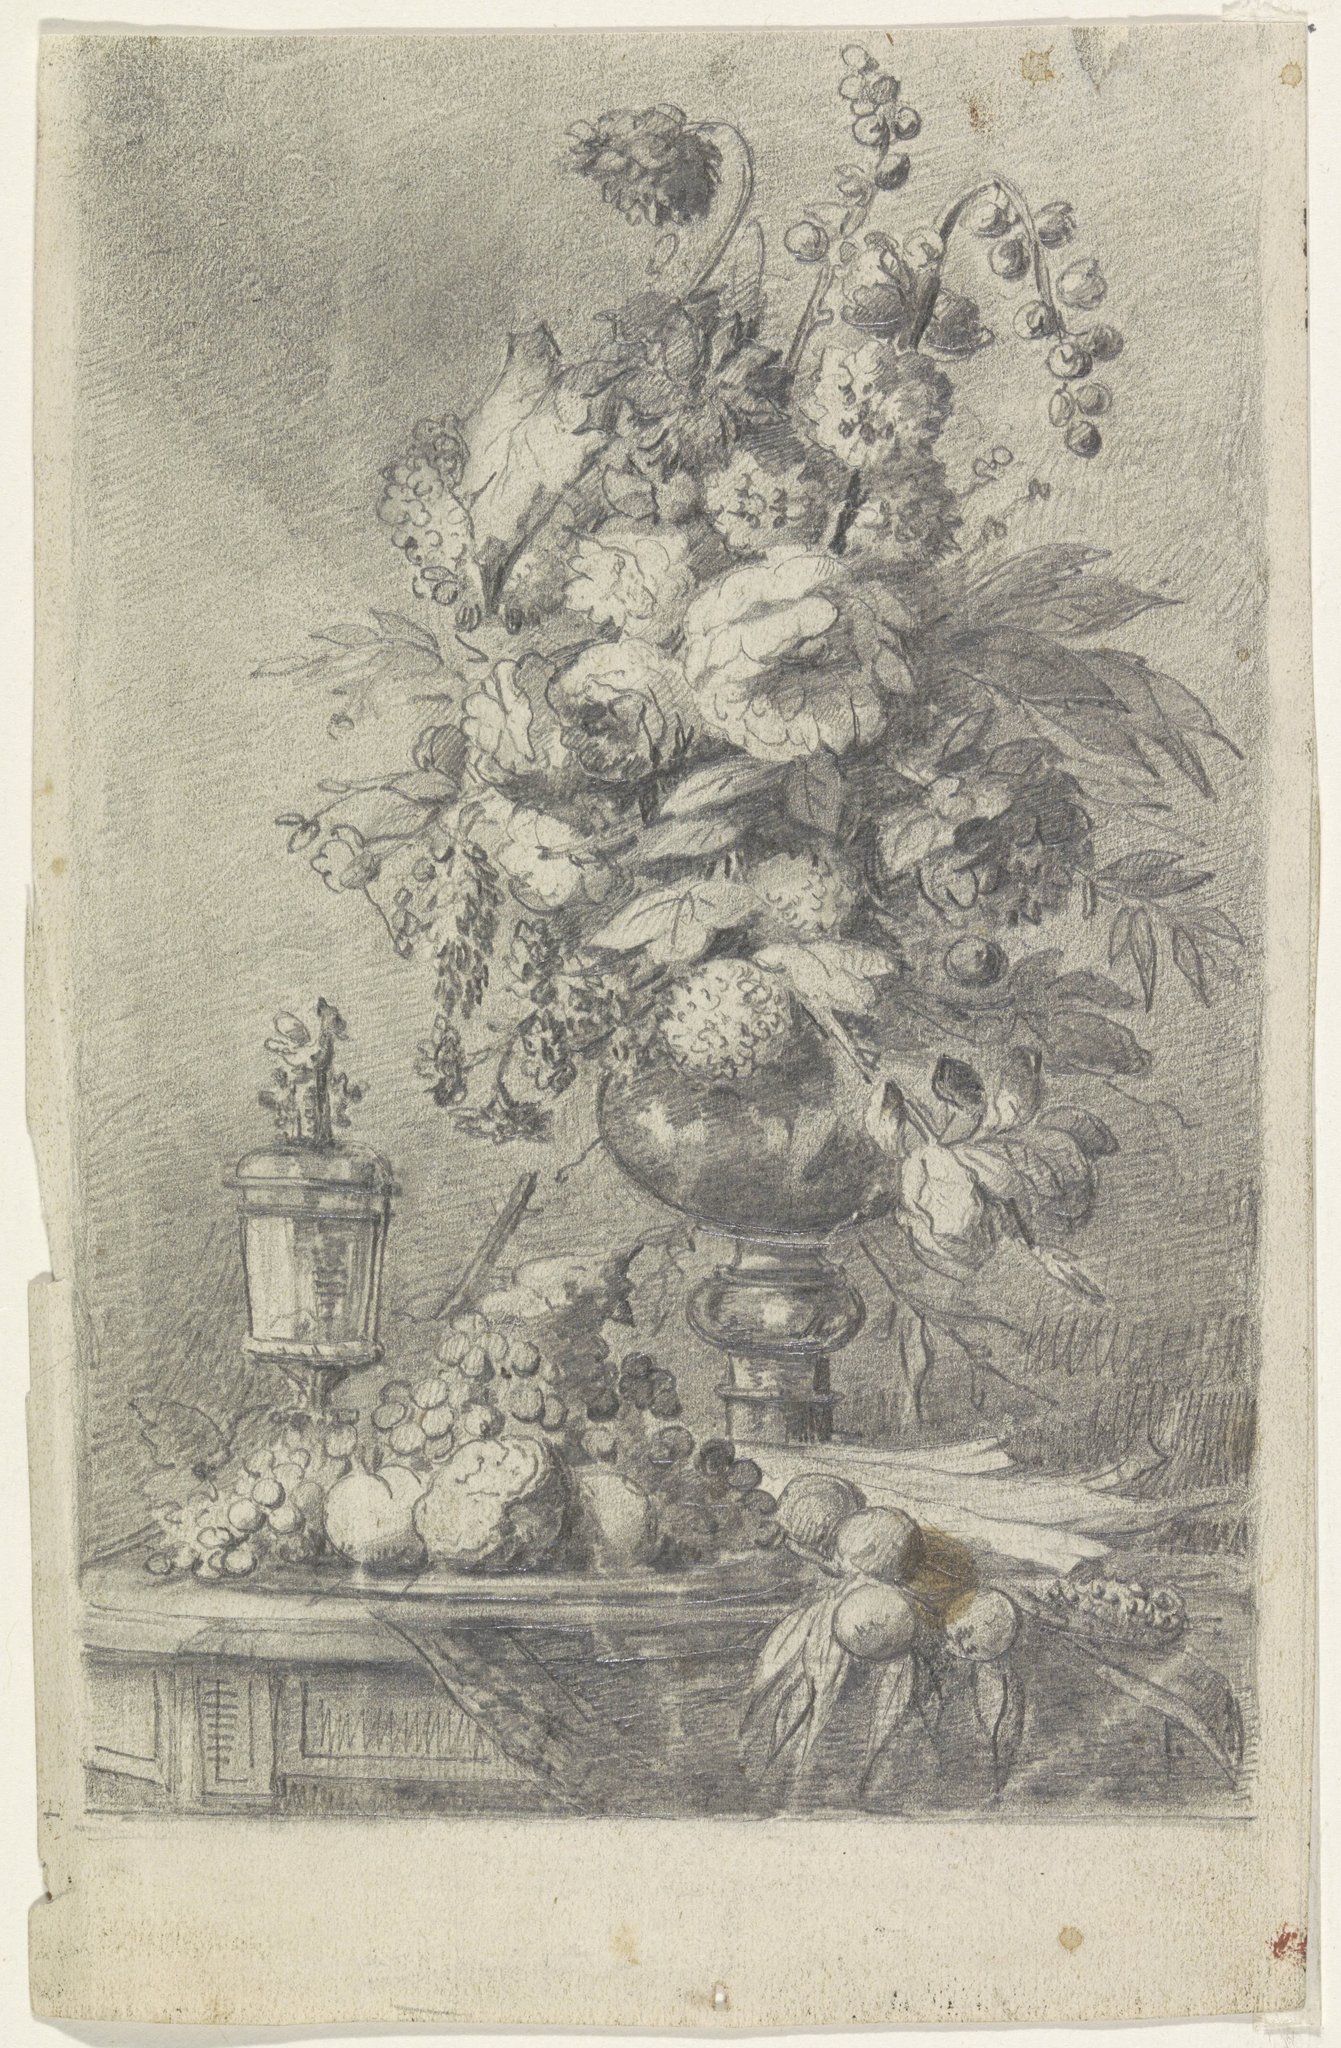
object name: drawing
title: Stilleven met een schaal vruchten en een vaas met bloemen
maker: lucas victor schaefels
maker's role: draughtsman, print maker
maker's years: 1824-1885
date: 1834-1885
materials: chalk, paper, pencil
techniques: pouncing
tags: fruit, still life of related objects